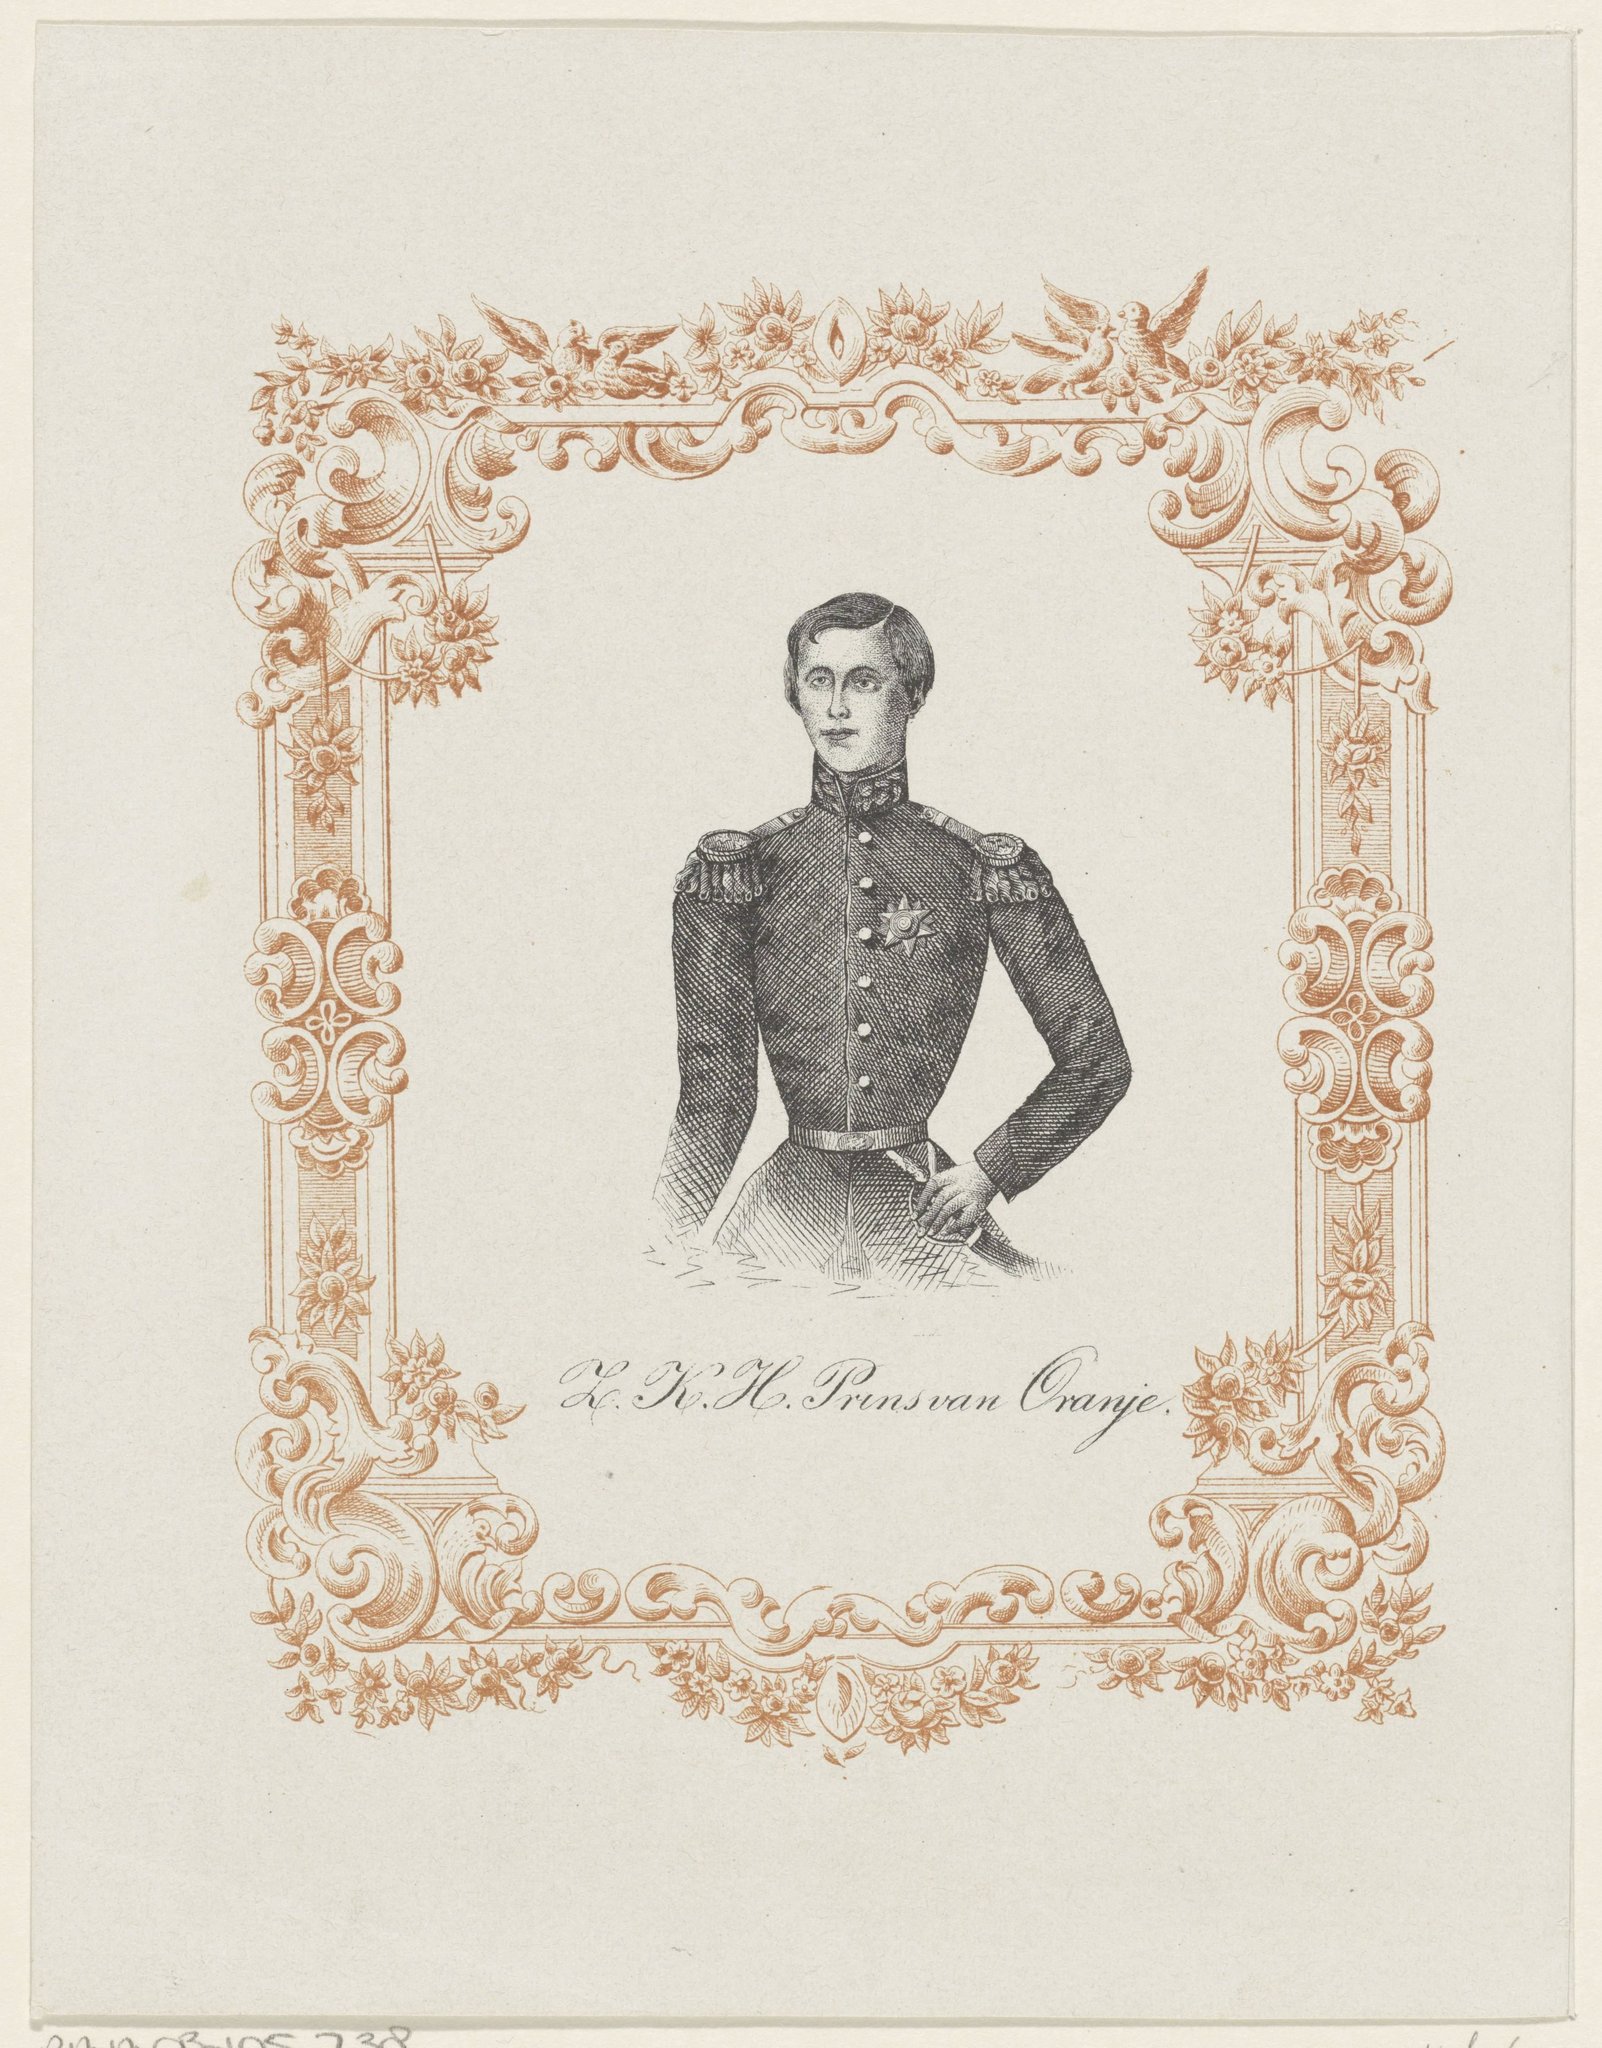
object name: print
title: Portret van Willem, prins der Nederlanden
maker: Anonymous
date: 1850-1949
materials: paper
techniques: lithograph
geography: netherlands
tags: the hague, paris, willem (prins der nederlanden)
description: De hier vermelde titel verwijst naar de hoogst verkregen titel van de geportretteerde, niet per se naar de titel die de geportretteerde op deze voorstelling draagt.